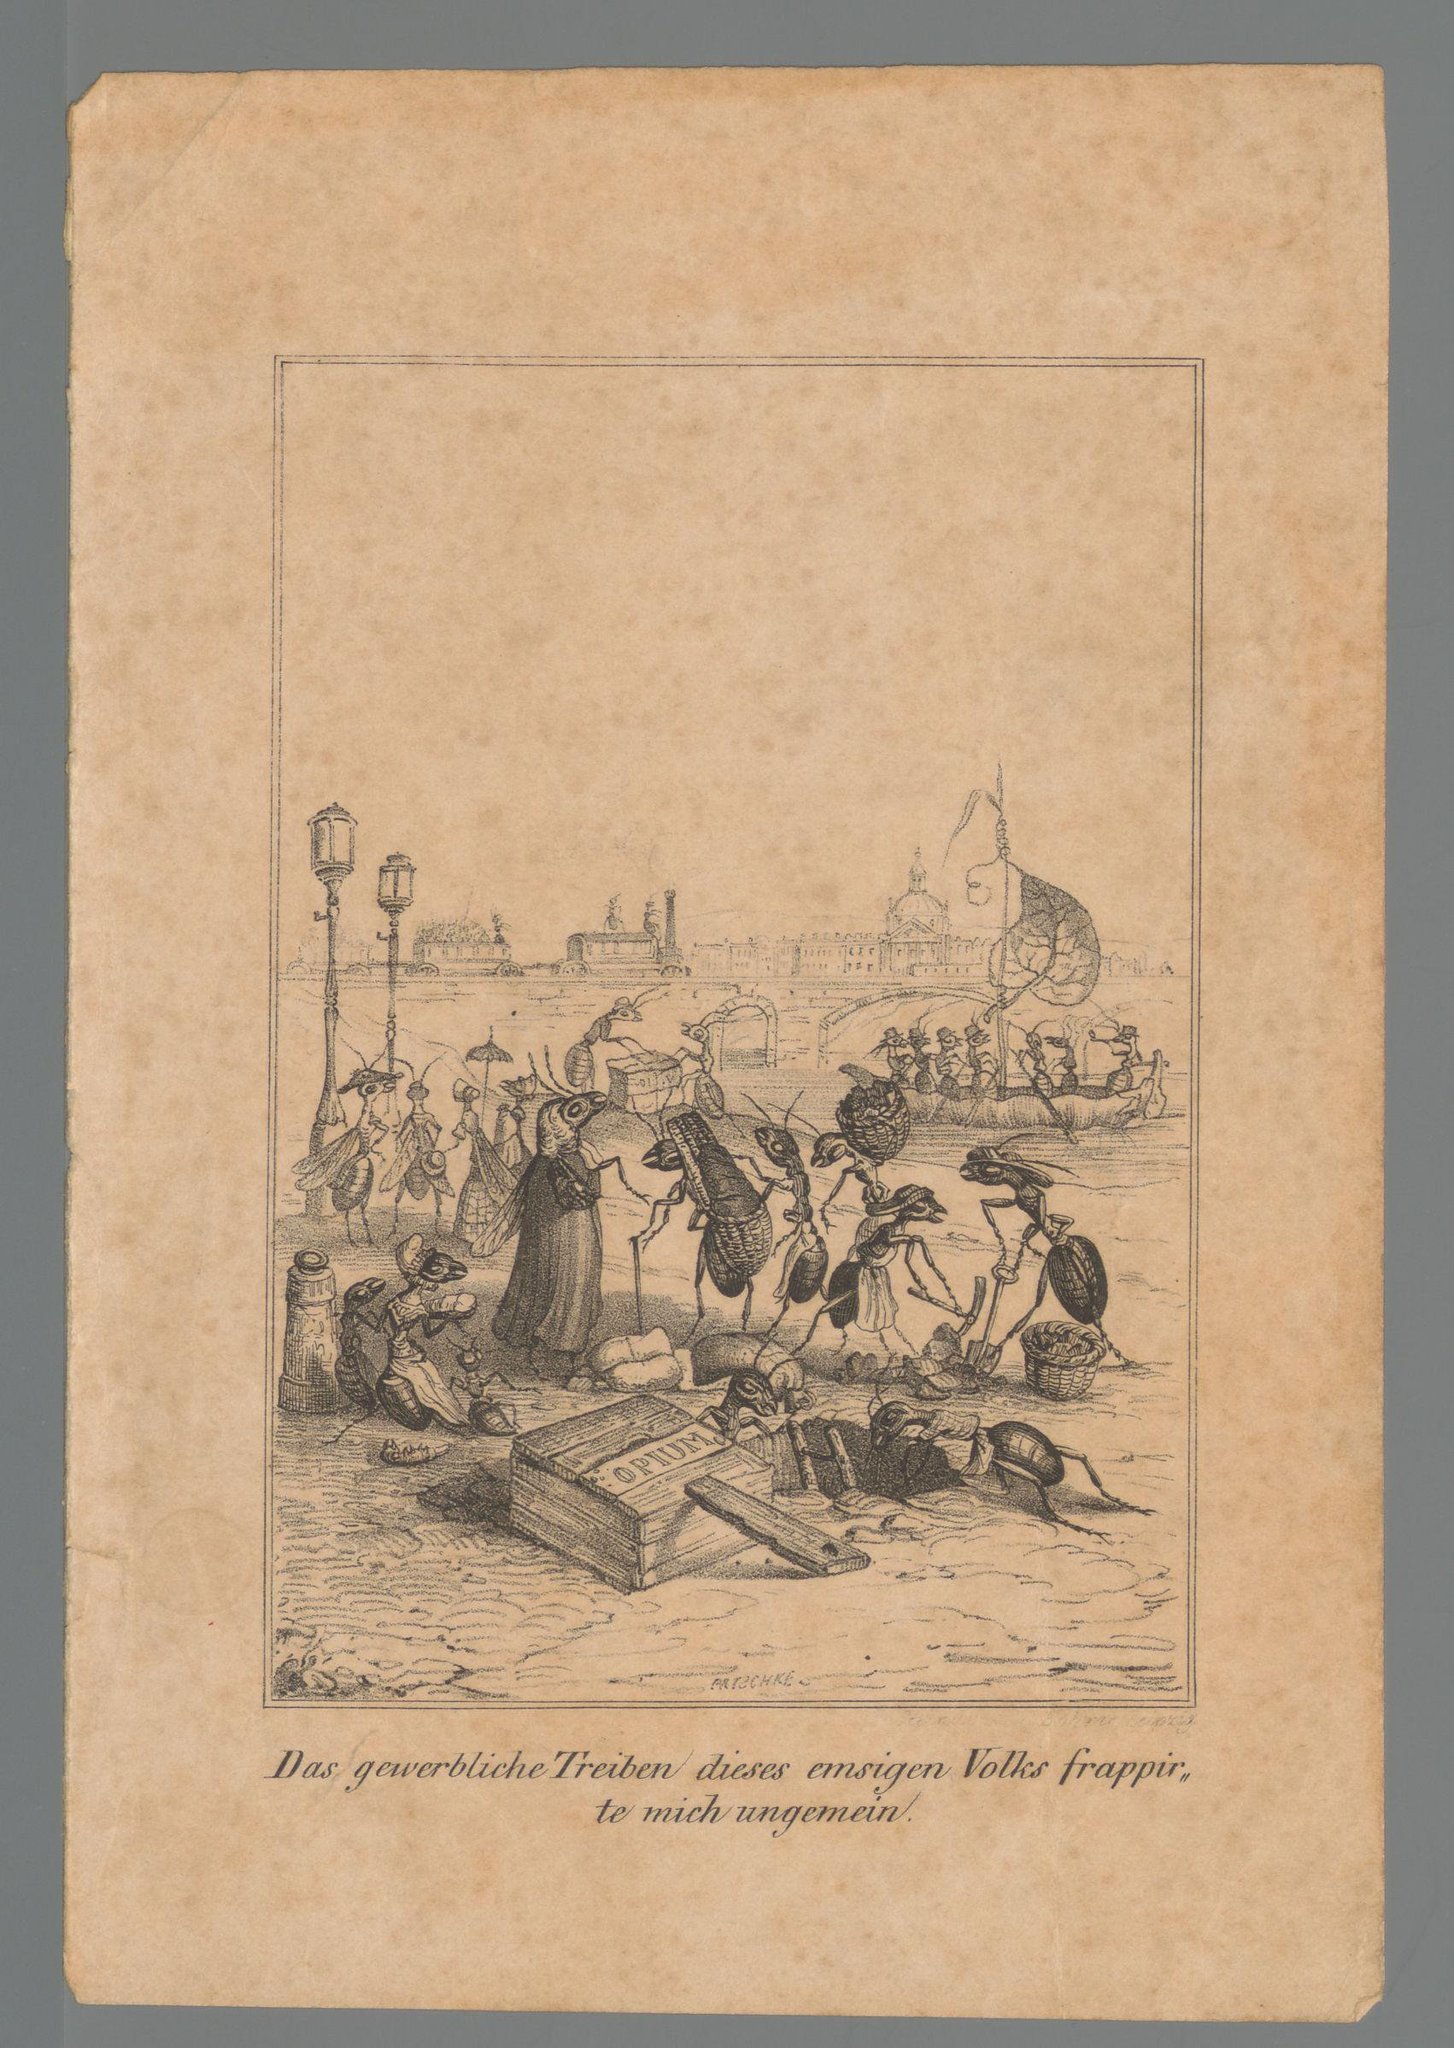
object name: book illustration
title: Das gewerbliche Treiben dieses emsigen Volks frappirte mich ungemein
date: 1841-1842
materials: paper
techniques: lithograph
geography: leipzig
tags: insects: ant, opium, animals acting as human beings, bridge in city across river, canal, etc.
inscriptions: collector's mark: Lugt 2228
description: Prent uit: Gerard, Jean-Ignace-Isidore. Das neunzehnte Jahrhundert des Thierreichs oder Scenen aus dem Familien- und Staatsleben der Thiere. Leipzig: Friedrich Volckmar, [1841-1842].